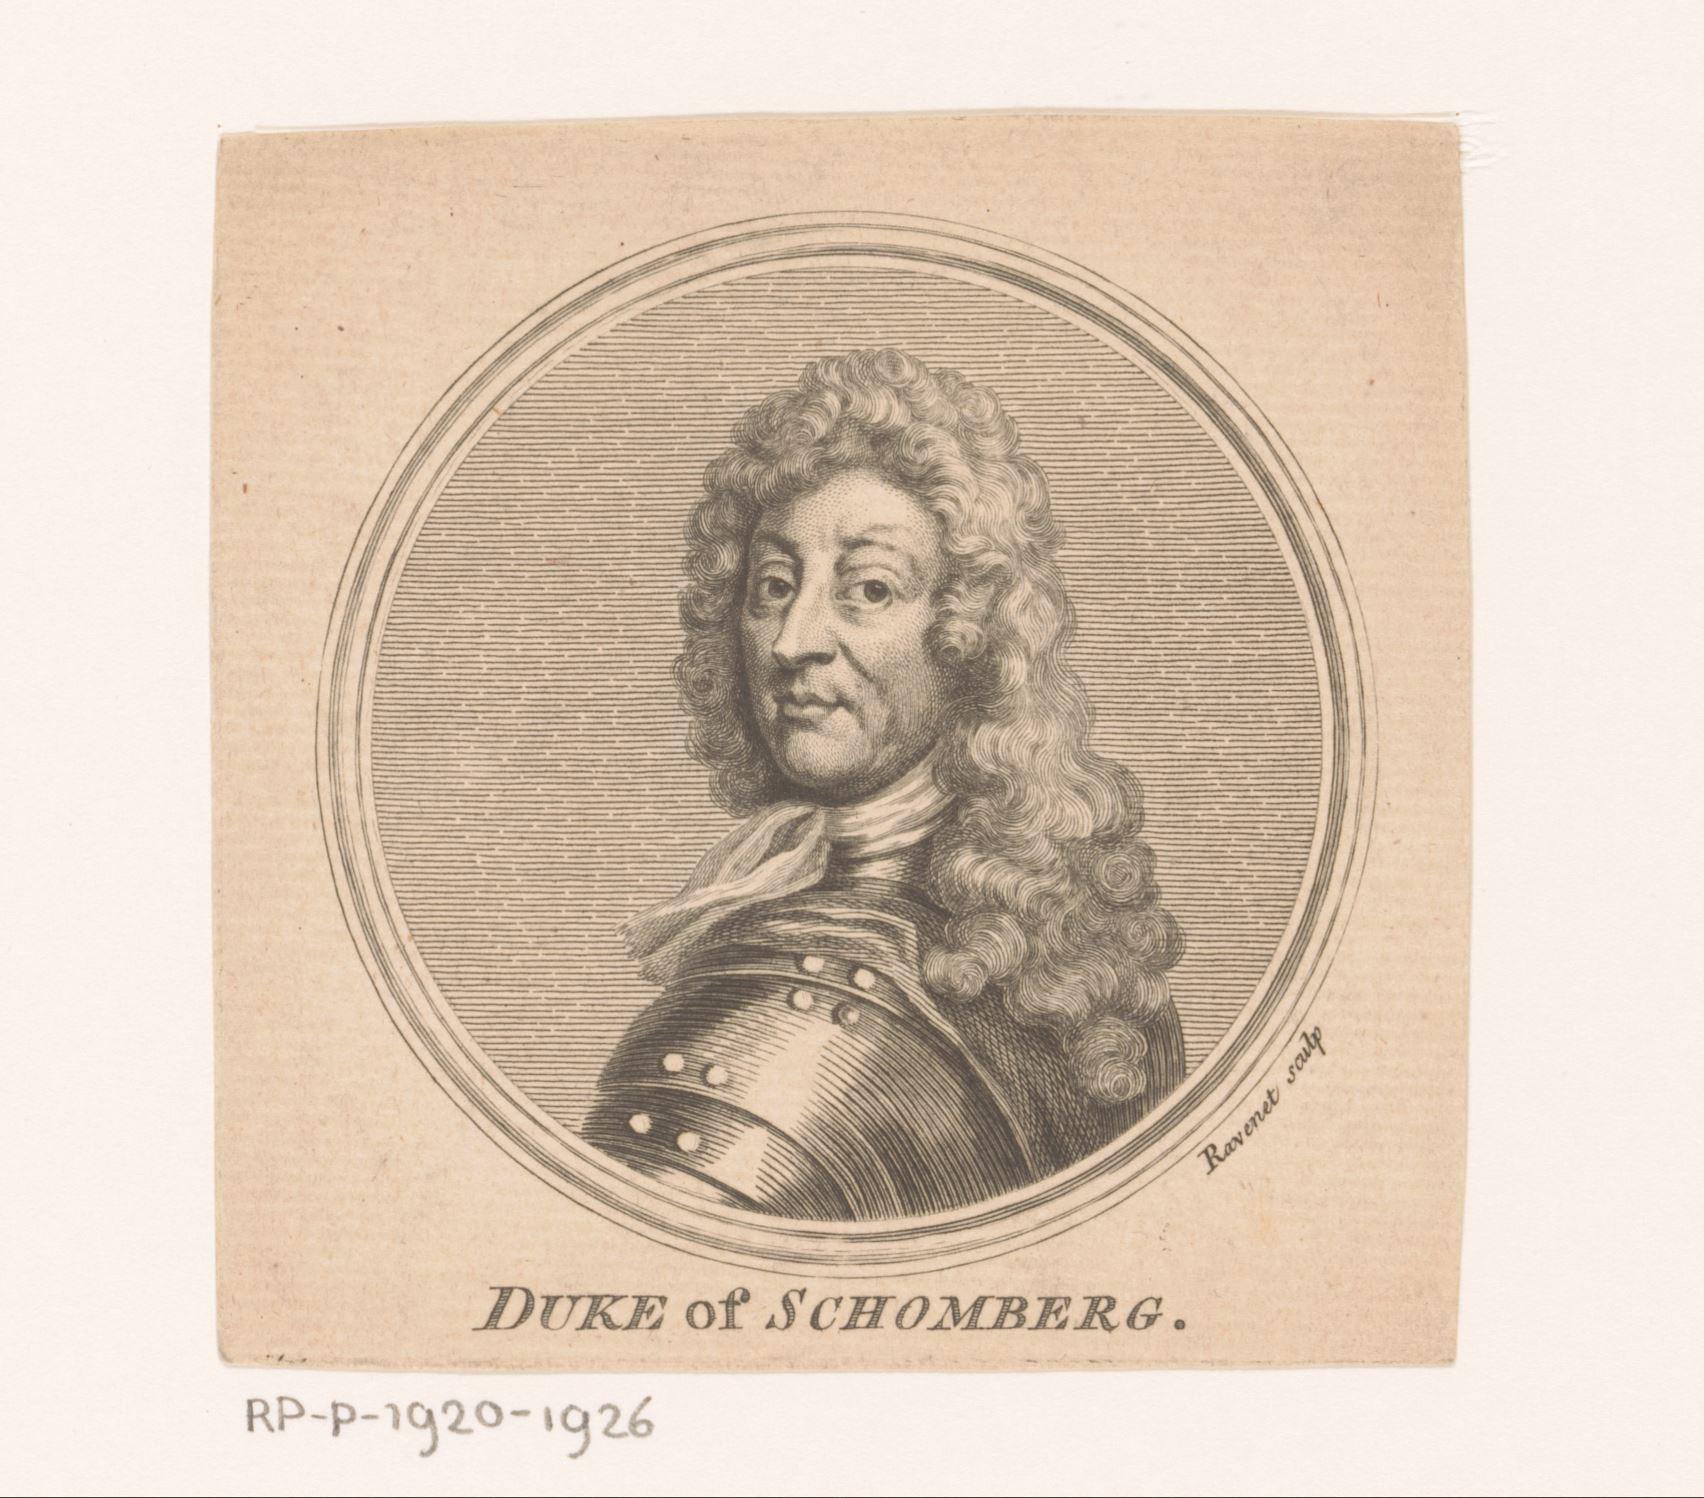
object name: print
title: Portret van Friedrich Arnaud, hertog van Schomberg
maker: simon françois ravenet (le vieux)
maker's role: print maker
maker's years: 1706-1774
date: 1716-1774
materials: paper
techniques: engraving, etching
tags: ranks in the army, historical persons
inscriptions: collector's mark: Lugt 2228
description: De hertog van Schomberg, naar links gewend.